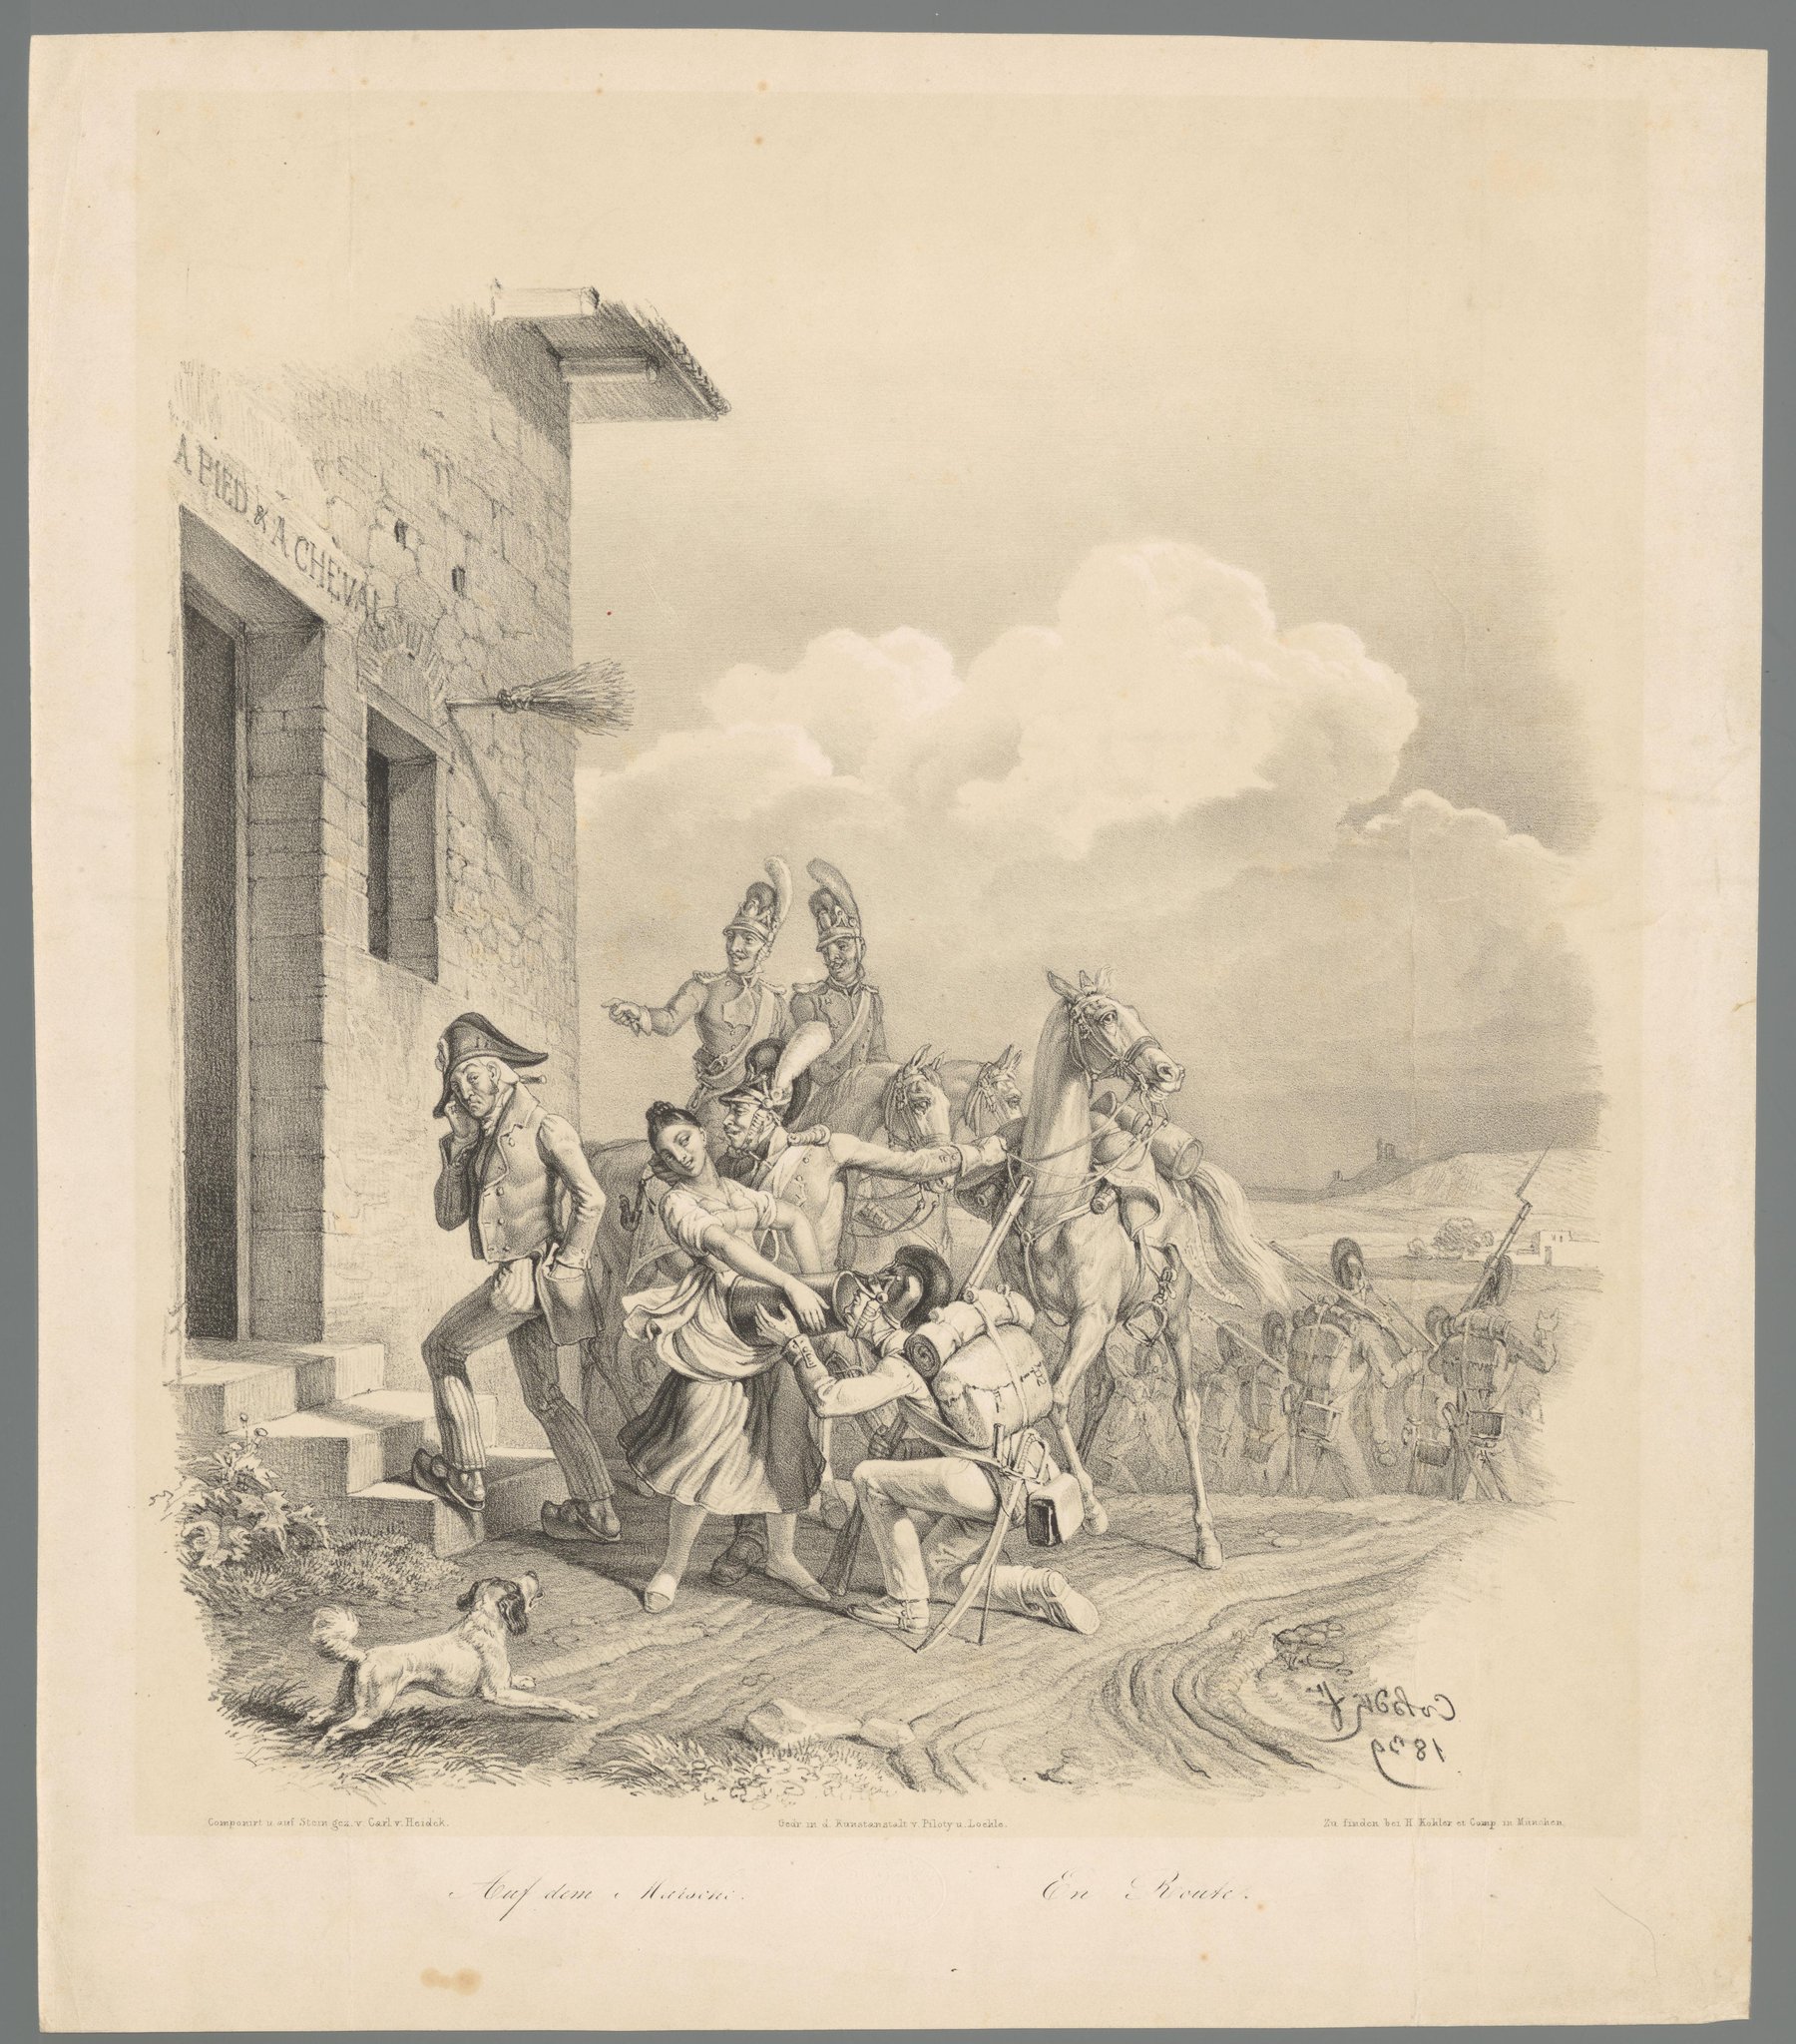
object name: print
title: Auf dem Marsche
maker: carl wilhelm freiherr von heideck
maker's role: print maker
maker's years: 1788-1861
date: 1839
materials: paper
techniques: lithograph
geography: munich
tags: the soldier; the soldier's life, stall, stable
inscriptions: collector's mark: Lugt 2228